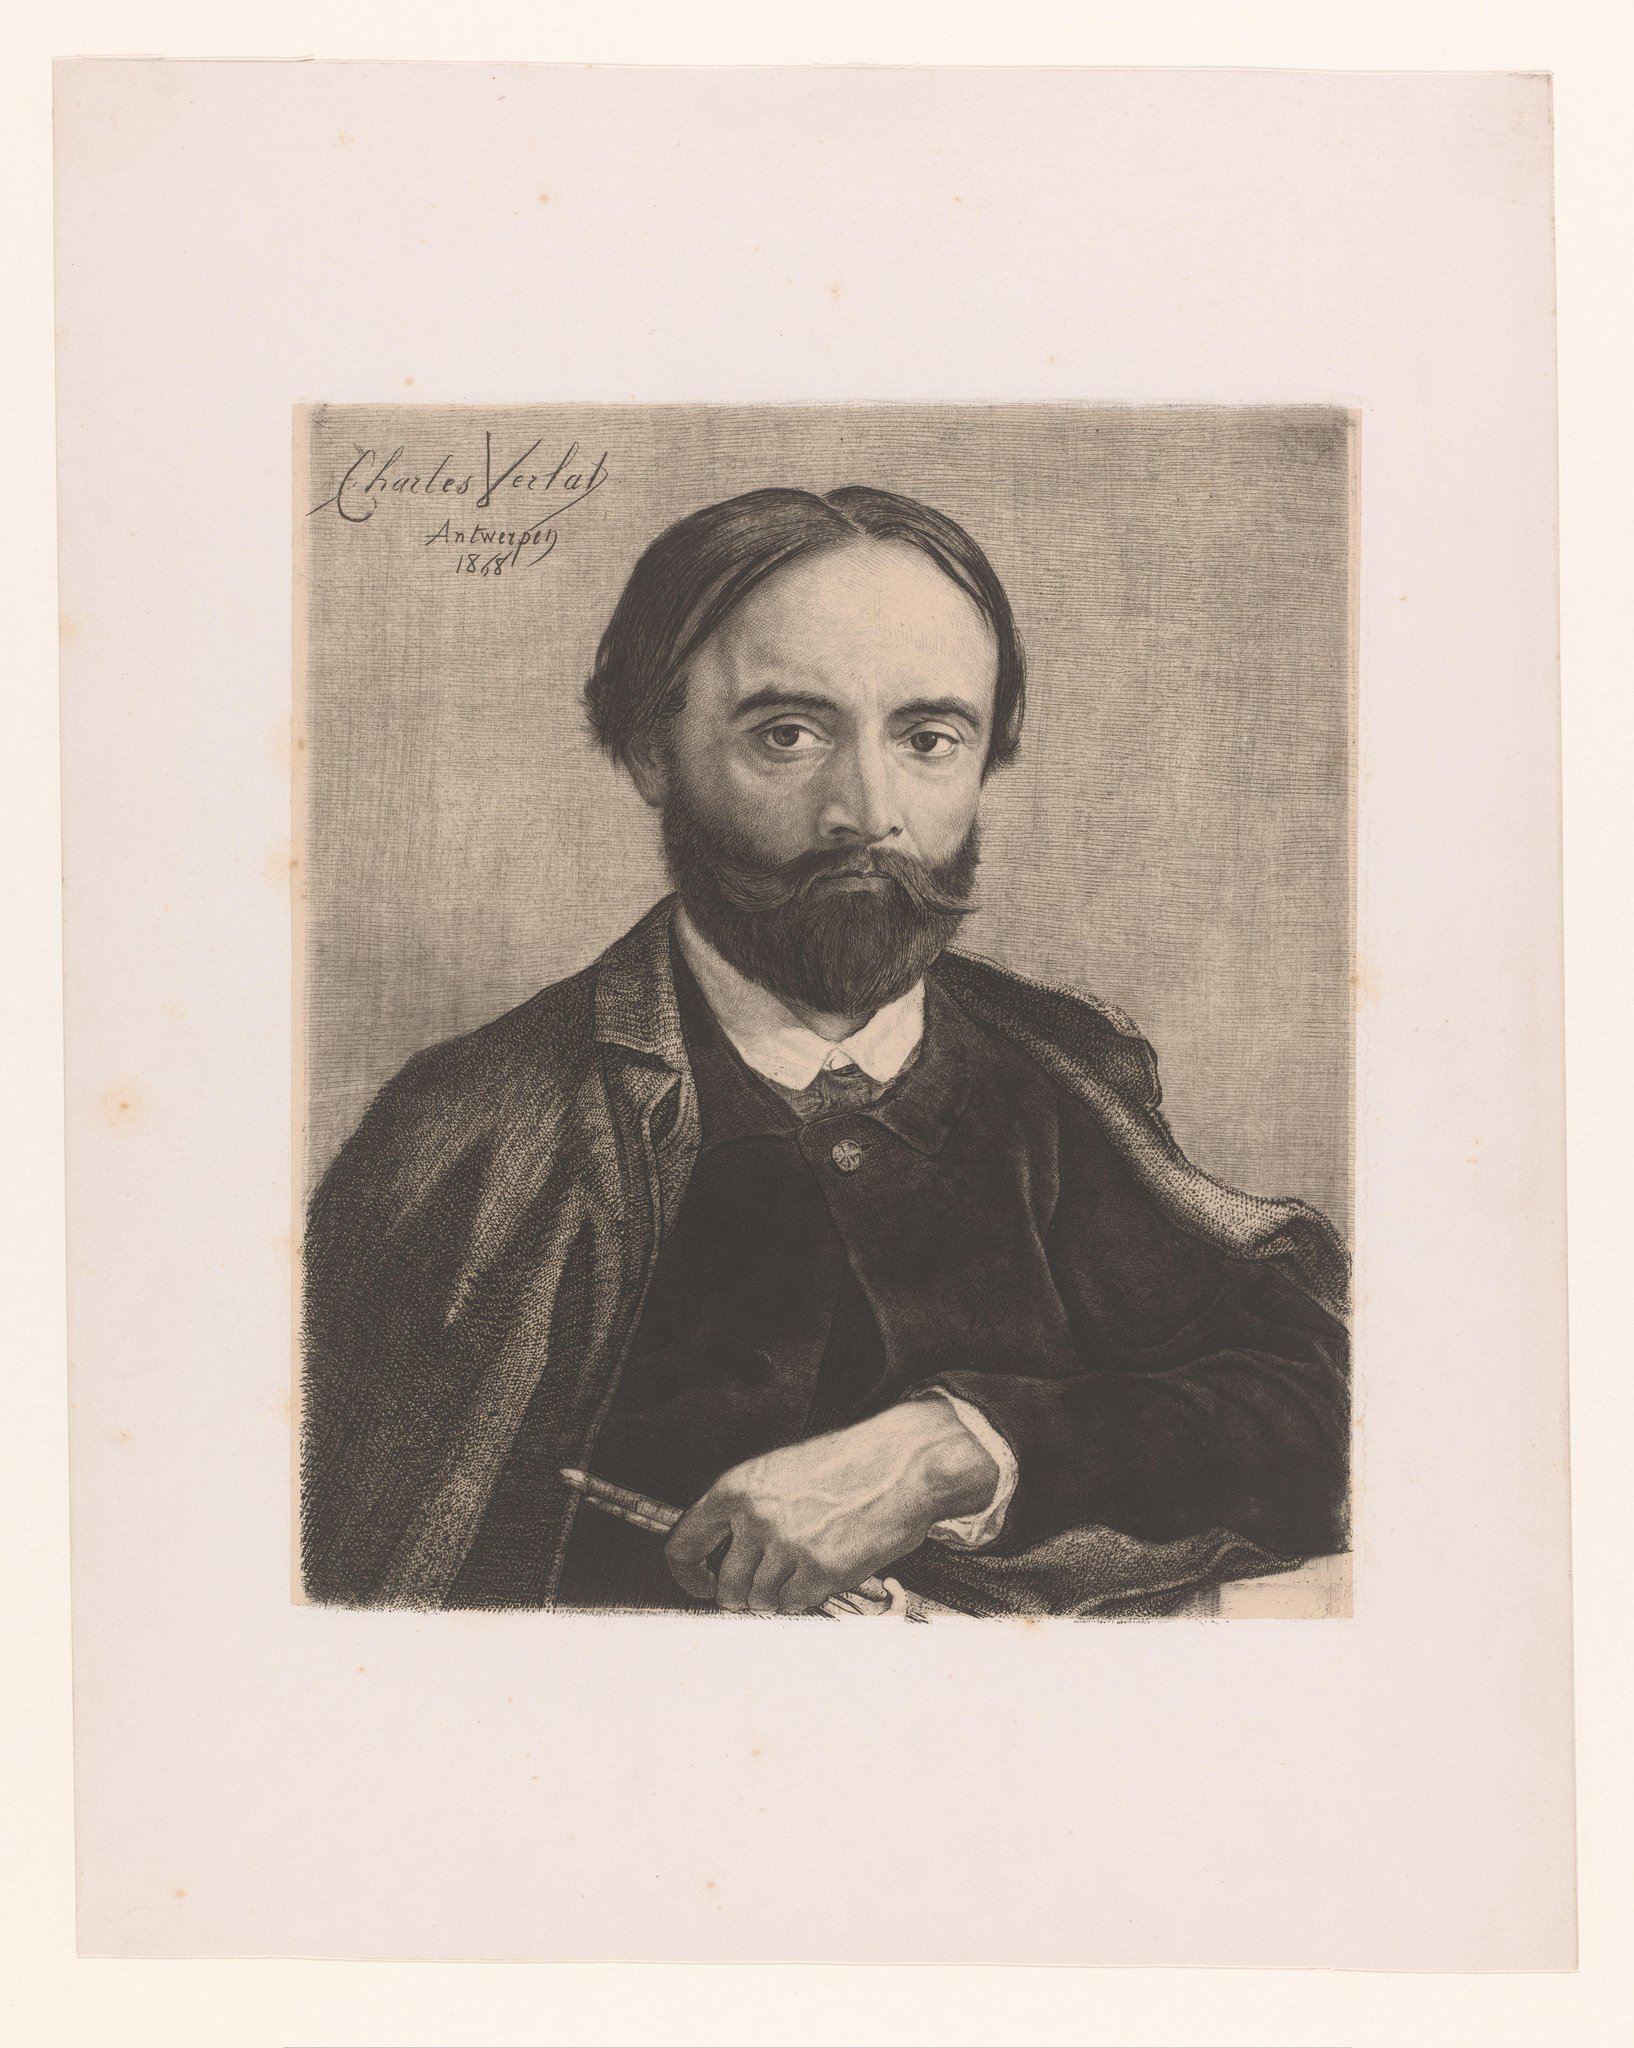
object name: print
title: Zelfportret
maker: charles verlat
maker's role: painter, print maker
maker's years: 1824-1890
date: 1868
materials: paper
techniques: drypoint, etching, intaglio, retroussage, roulette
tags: antwerp, painter, print maker, charles verlat, historical persons, portrait, self-portrait of artist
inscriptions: collector's mark: Lugt 2228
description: In 1868 maakte Verlat dit zelfportret. In 1882 bewerkte hij de plaat en gaf het gezicht oudere trekken. Dit deed hij in verschillende stappen waarvan de diverse staten ook in de coll. Rijksmuseum Amsterdam zijn. Het resultaat was een zelfportret dat meer paste bij hoe hij er op dat latere moment in zijn leven uitzag.